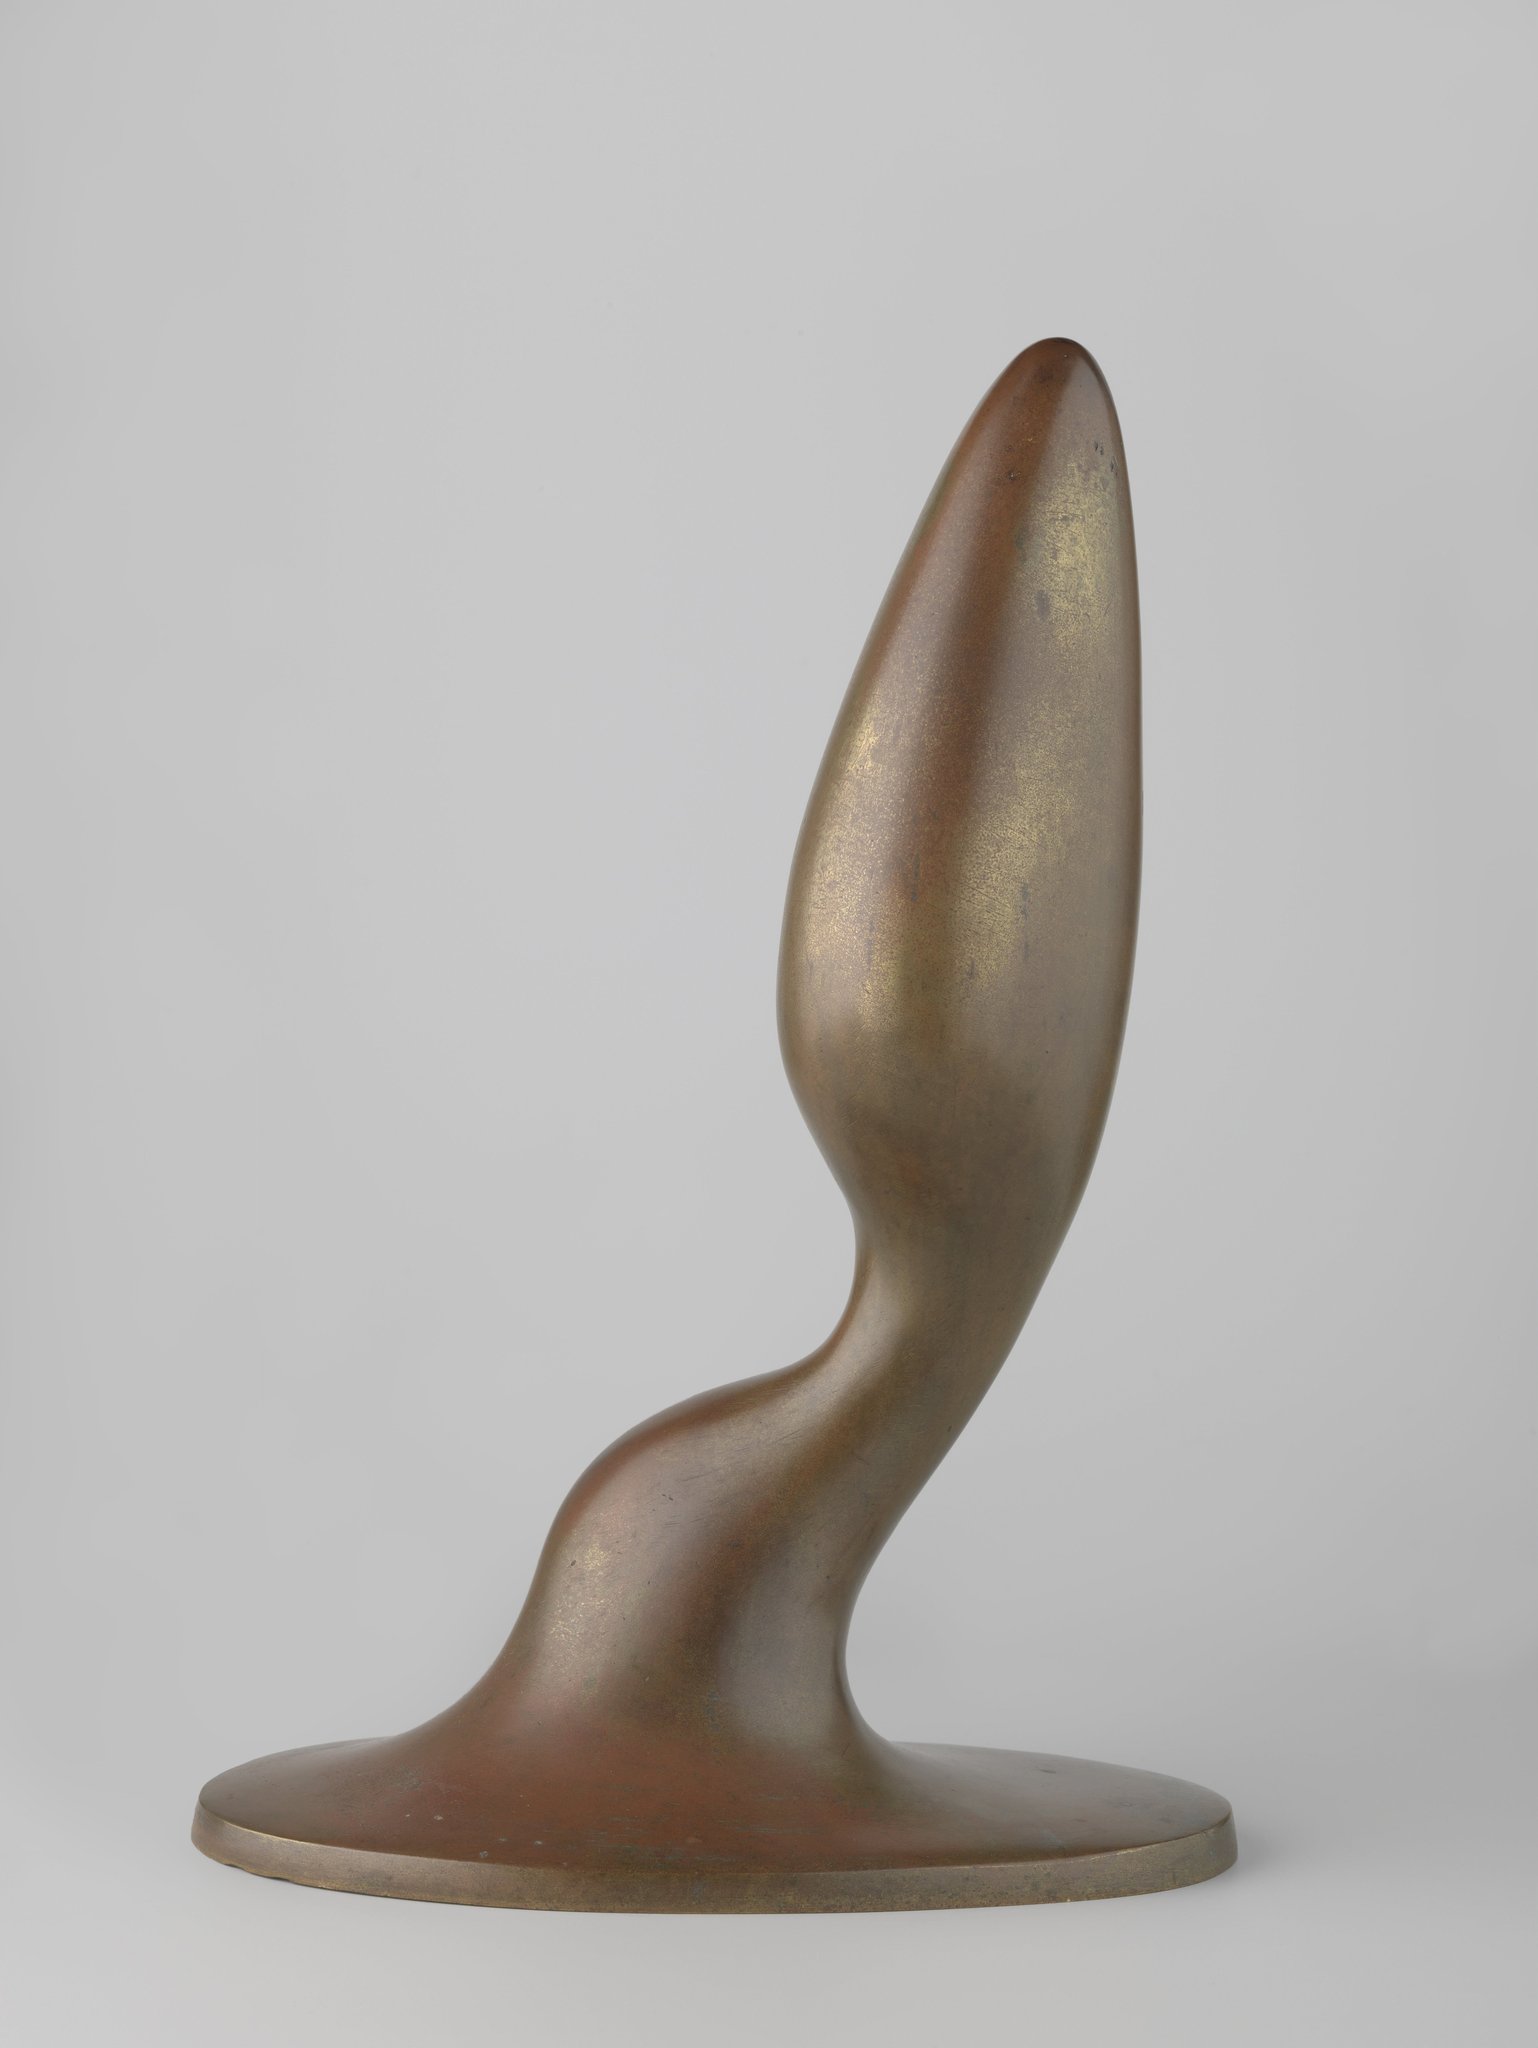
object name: sculpture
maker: jacob bendien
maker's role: draughtsman, print maker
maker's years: 1890-1933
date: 1933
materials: brass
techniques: casting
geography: amsterdam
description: Jacob Bendien and Jan van Deene, both from Amsterdam, became friends in Paris in 1912. They each found a studio in the Montparnasse district and made their first abstract paintings there. Twenty years later, Bendien created an abstract sculpture in the same style: an upward-pointing form that seems to want to break free from its pedestal.